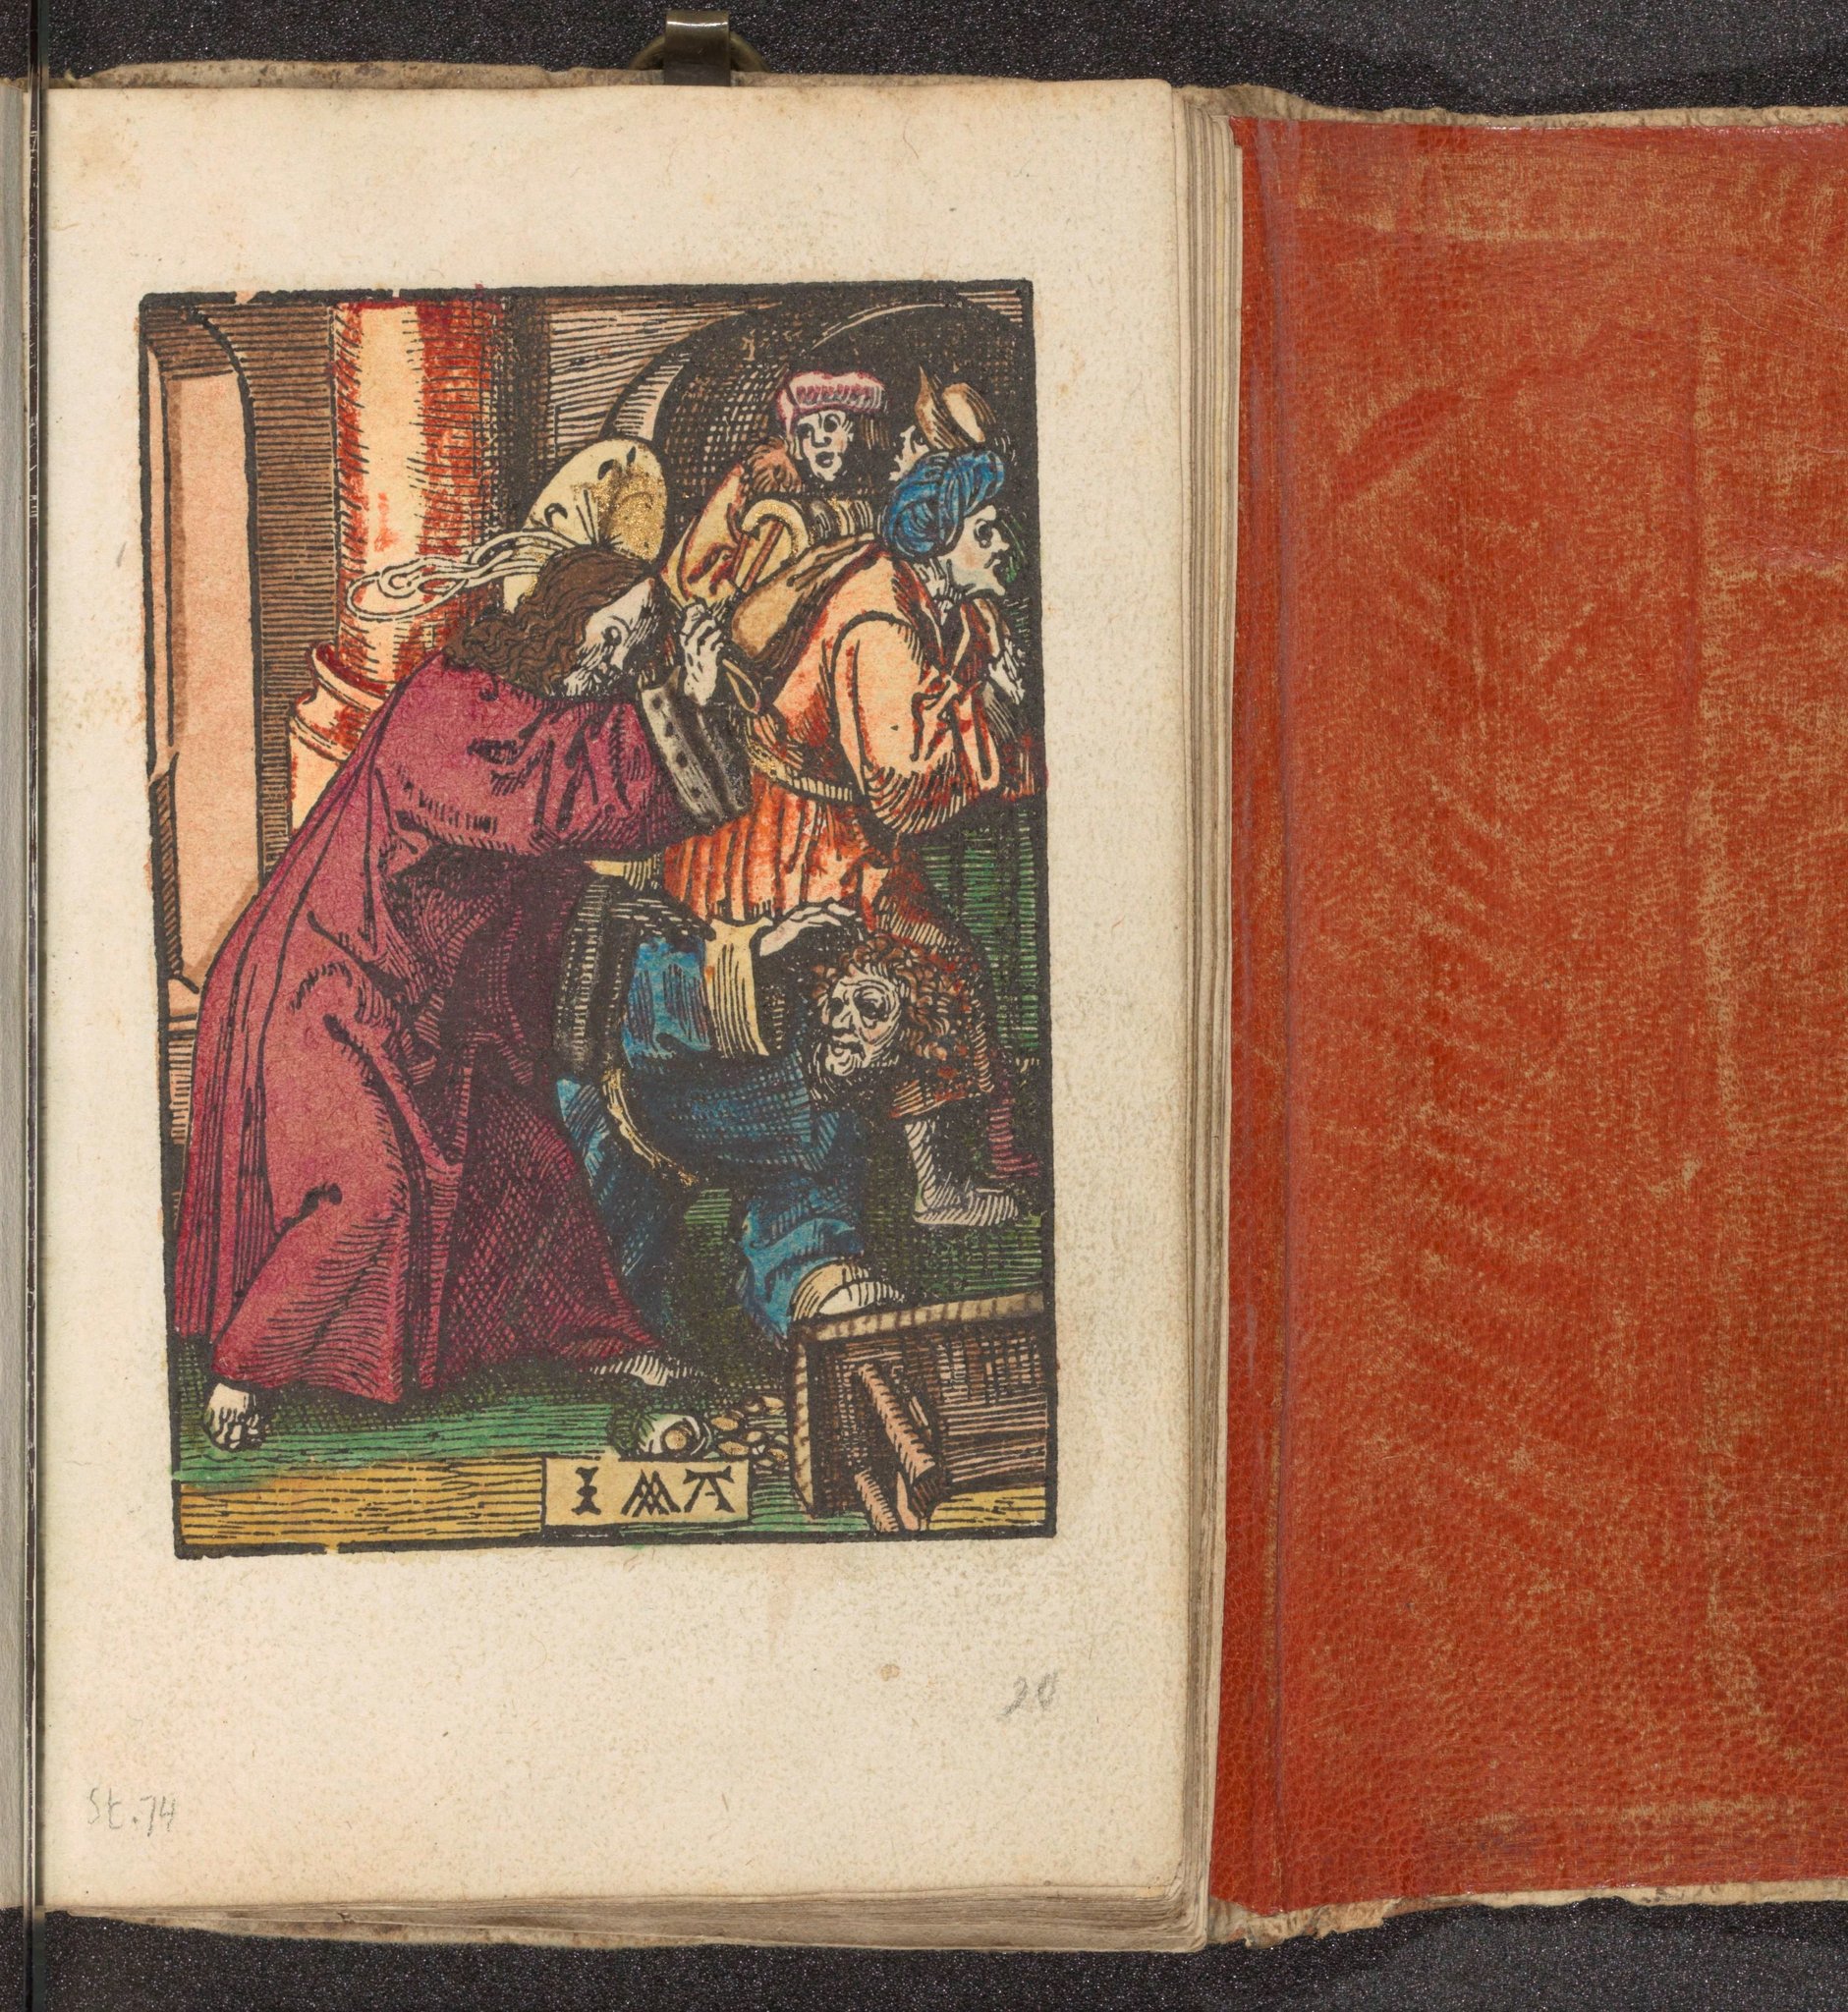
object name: album leaf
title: Stomme Passie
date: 1520-1521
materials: paper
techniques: hand coloring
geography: amsterdam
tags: book in which illustrations are essential, purification of the temple ('first' and 'second'): christ driving the money-changers from the temple with a whip (matthew 21:12-13; mark 11:15-17; luke 19:45-46; john 12:12-19)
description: Christus verjaagt met een zweep de geldwisselaars en handelaren uit de tempel. Een bank is omgevallen en muntstukken liggen op de grond. Prent maakt deel uit van een boek.